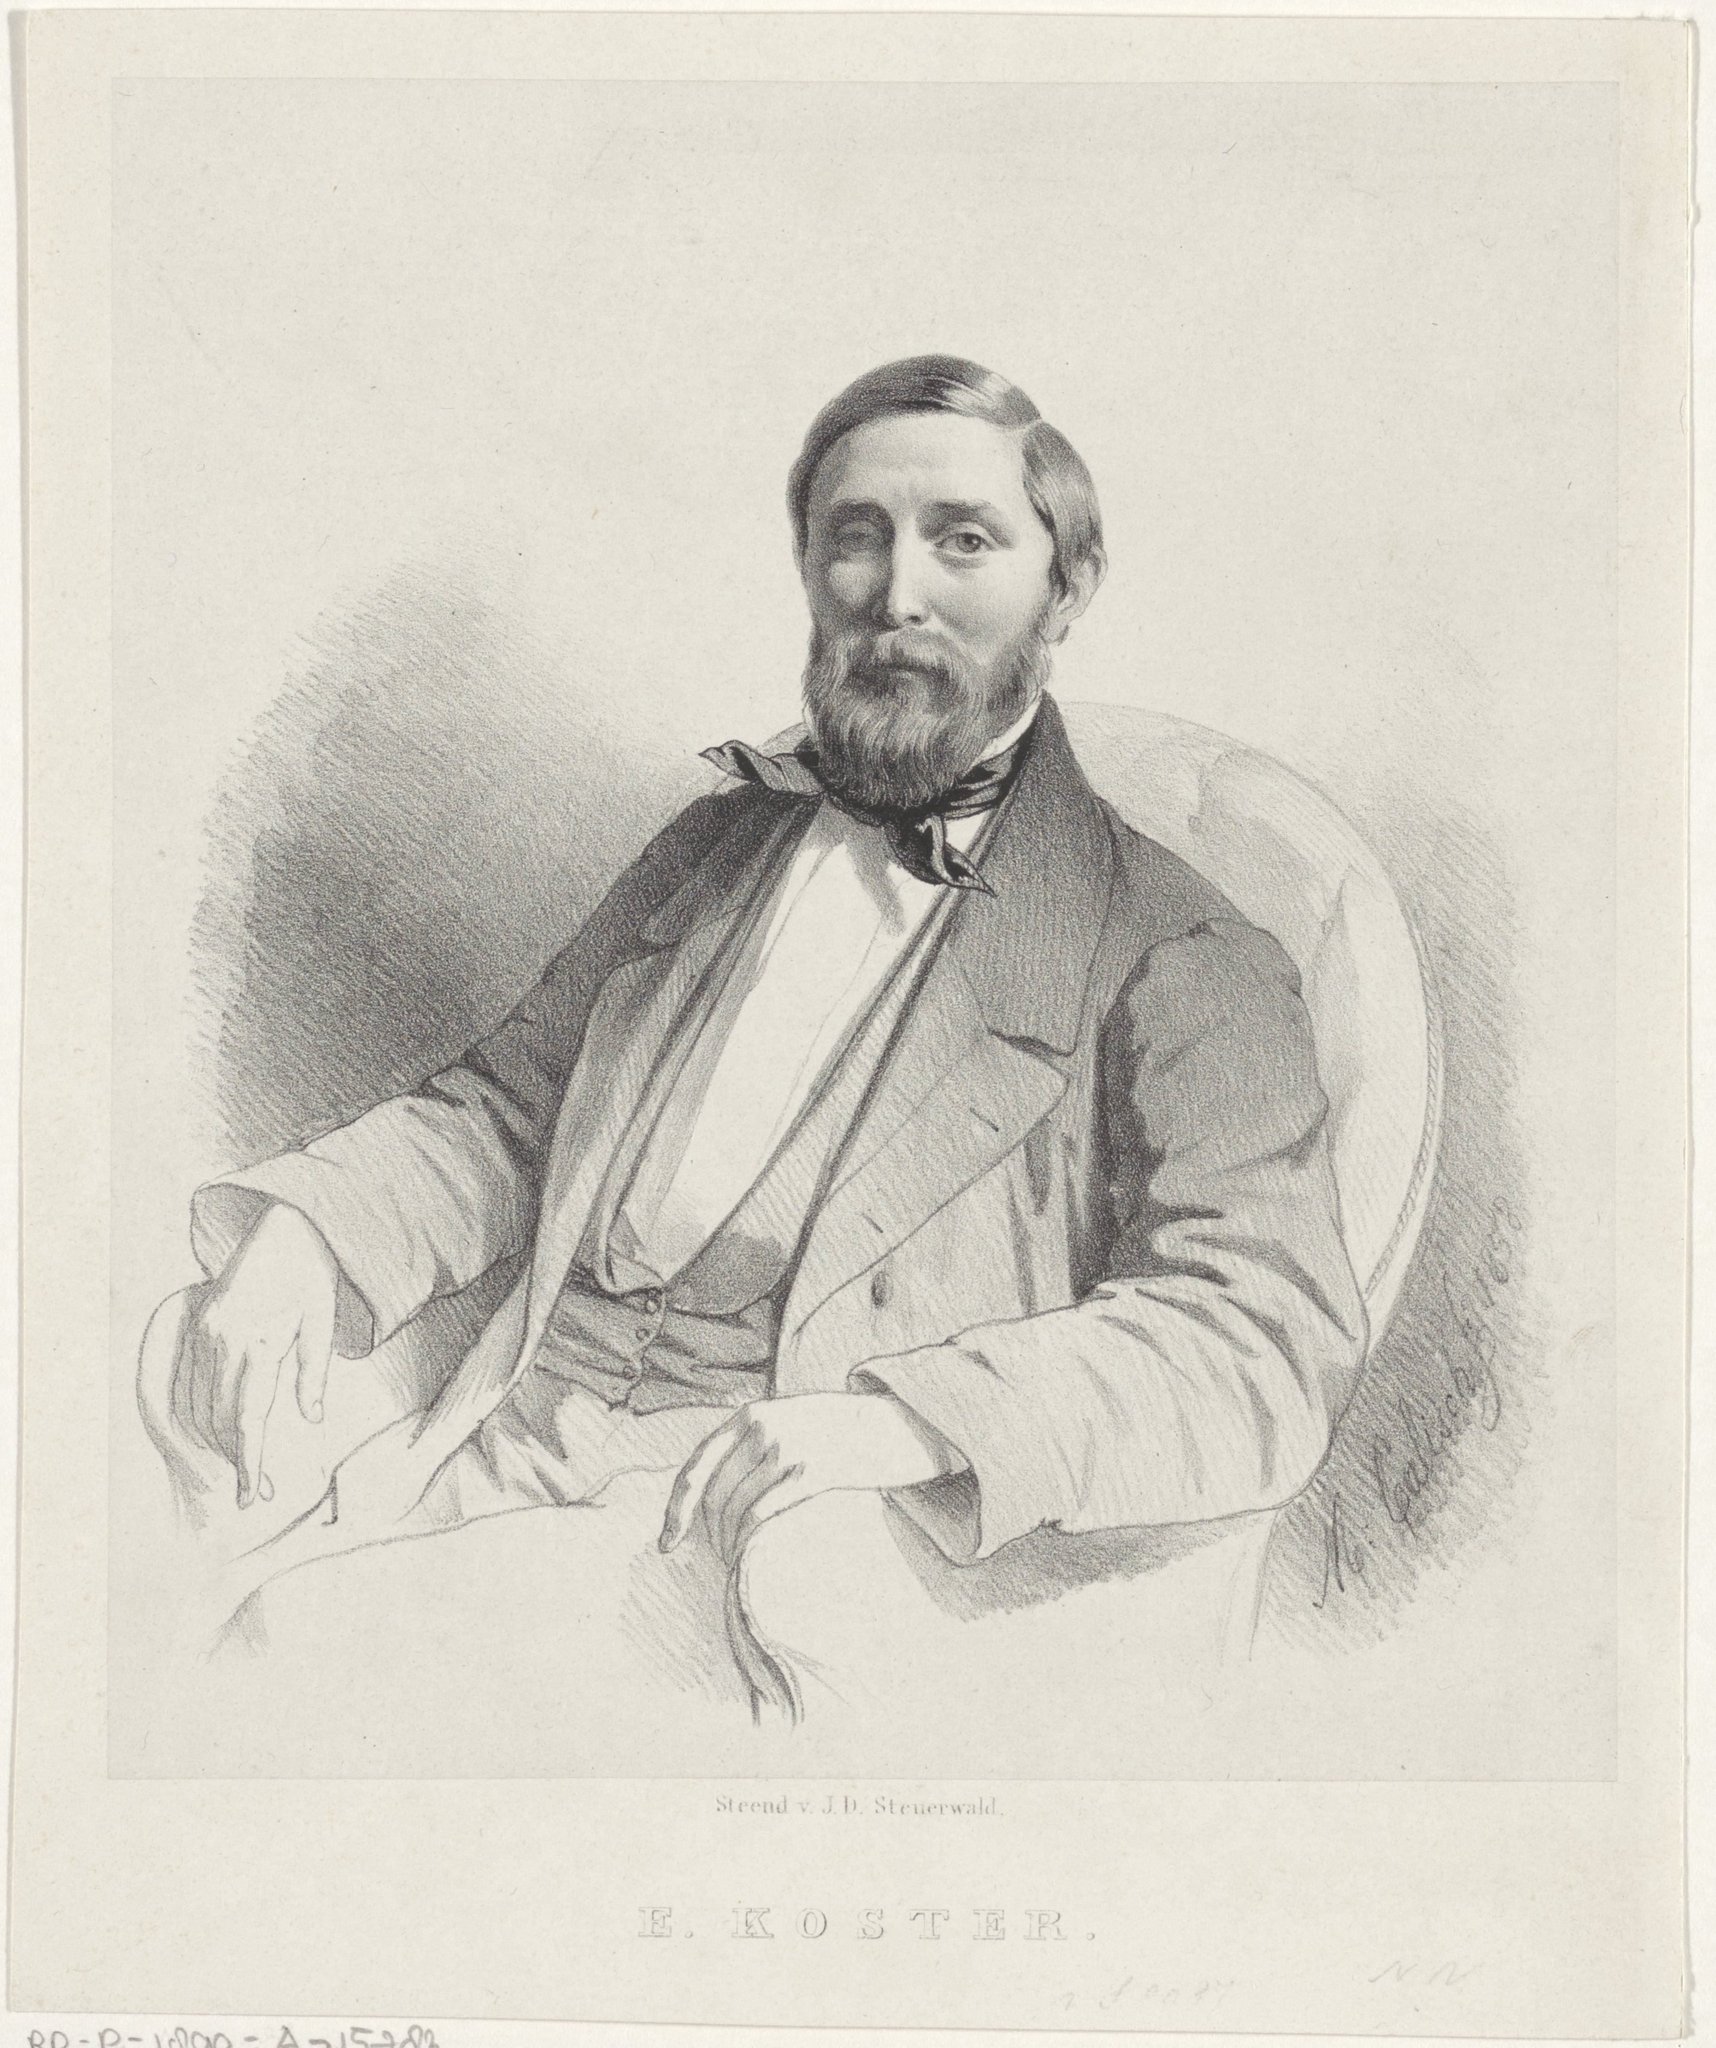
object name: print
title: Portret van Everhardus Koster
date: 1858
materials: paper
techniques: lithograph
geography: amsterdam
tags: dordrecht, painter, print maker, draughtsman, everhardus koster, adult man (+ sitting), armchair, seat, historical persons (+ three-quarter length portrait)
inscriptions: collector's mark: Lugt 2228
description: De geportretteerde zit in een fauteuil en rust met zijn armen op de armleuningen. Onder het portret zijn naam.